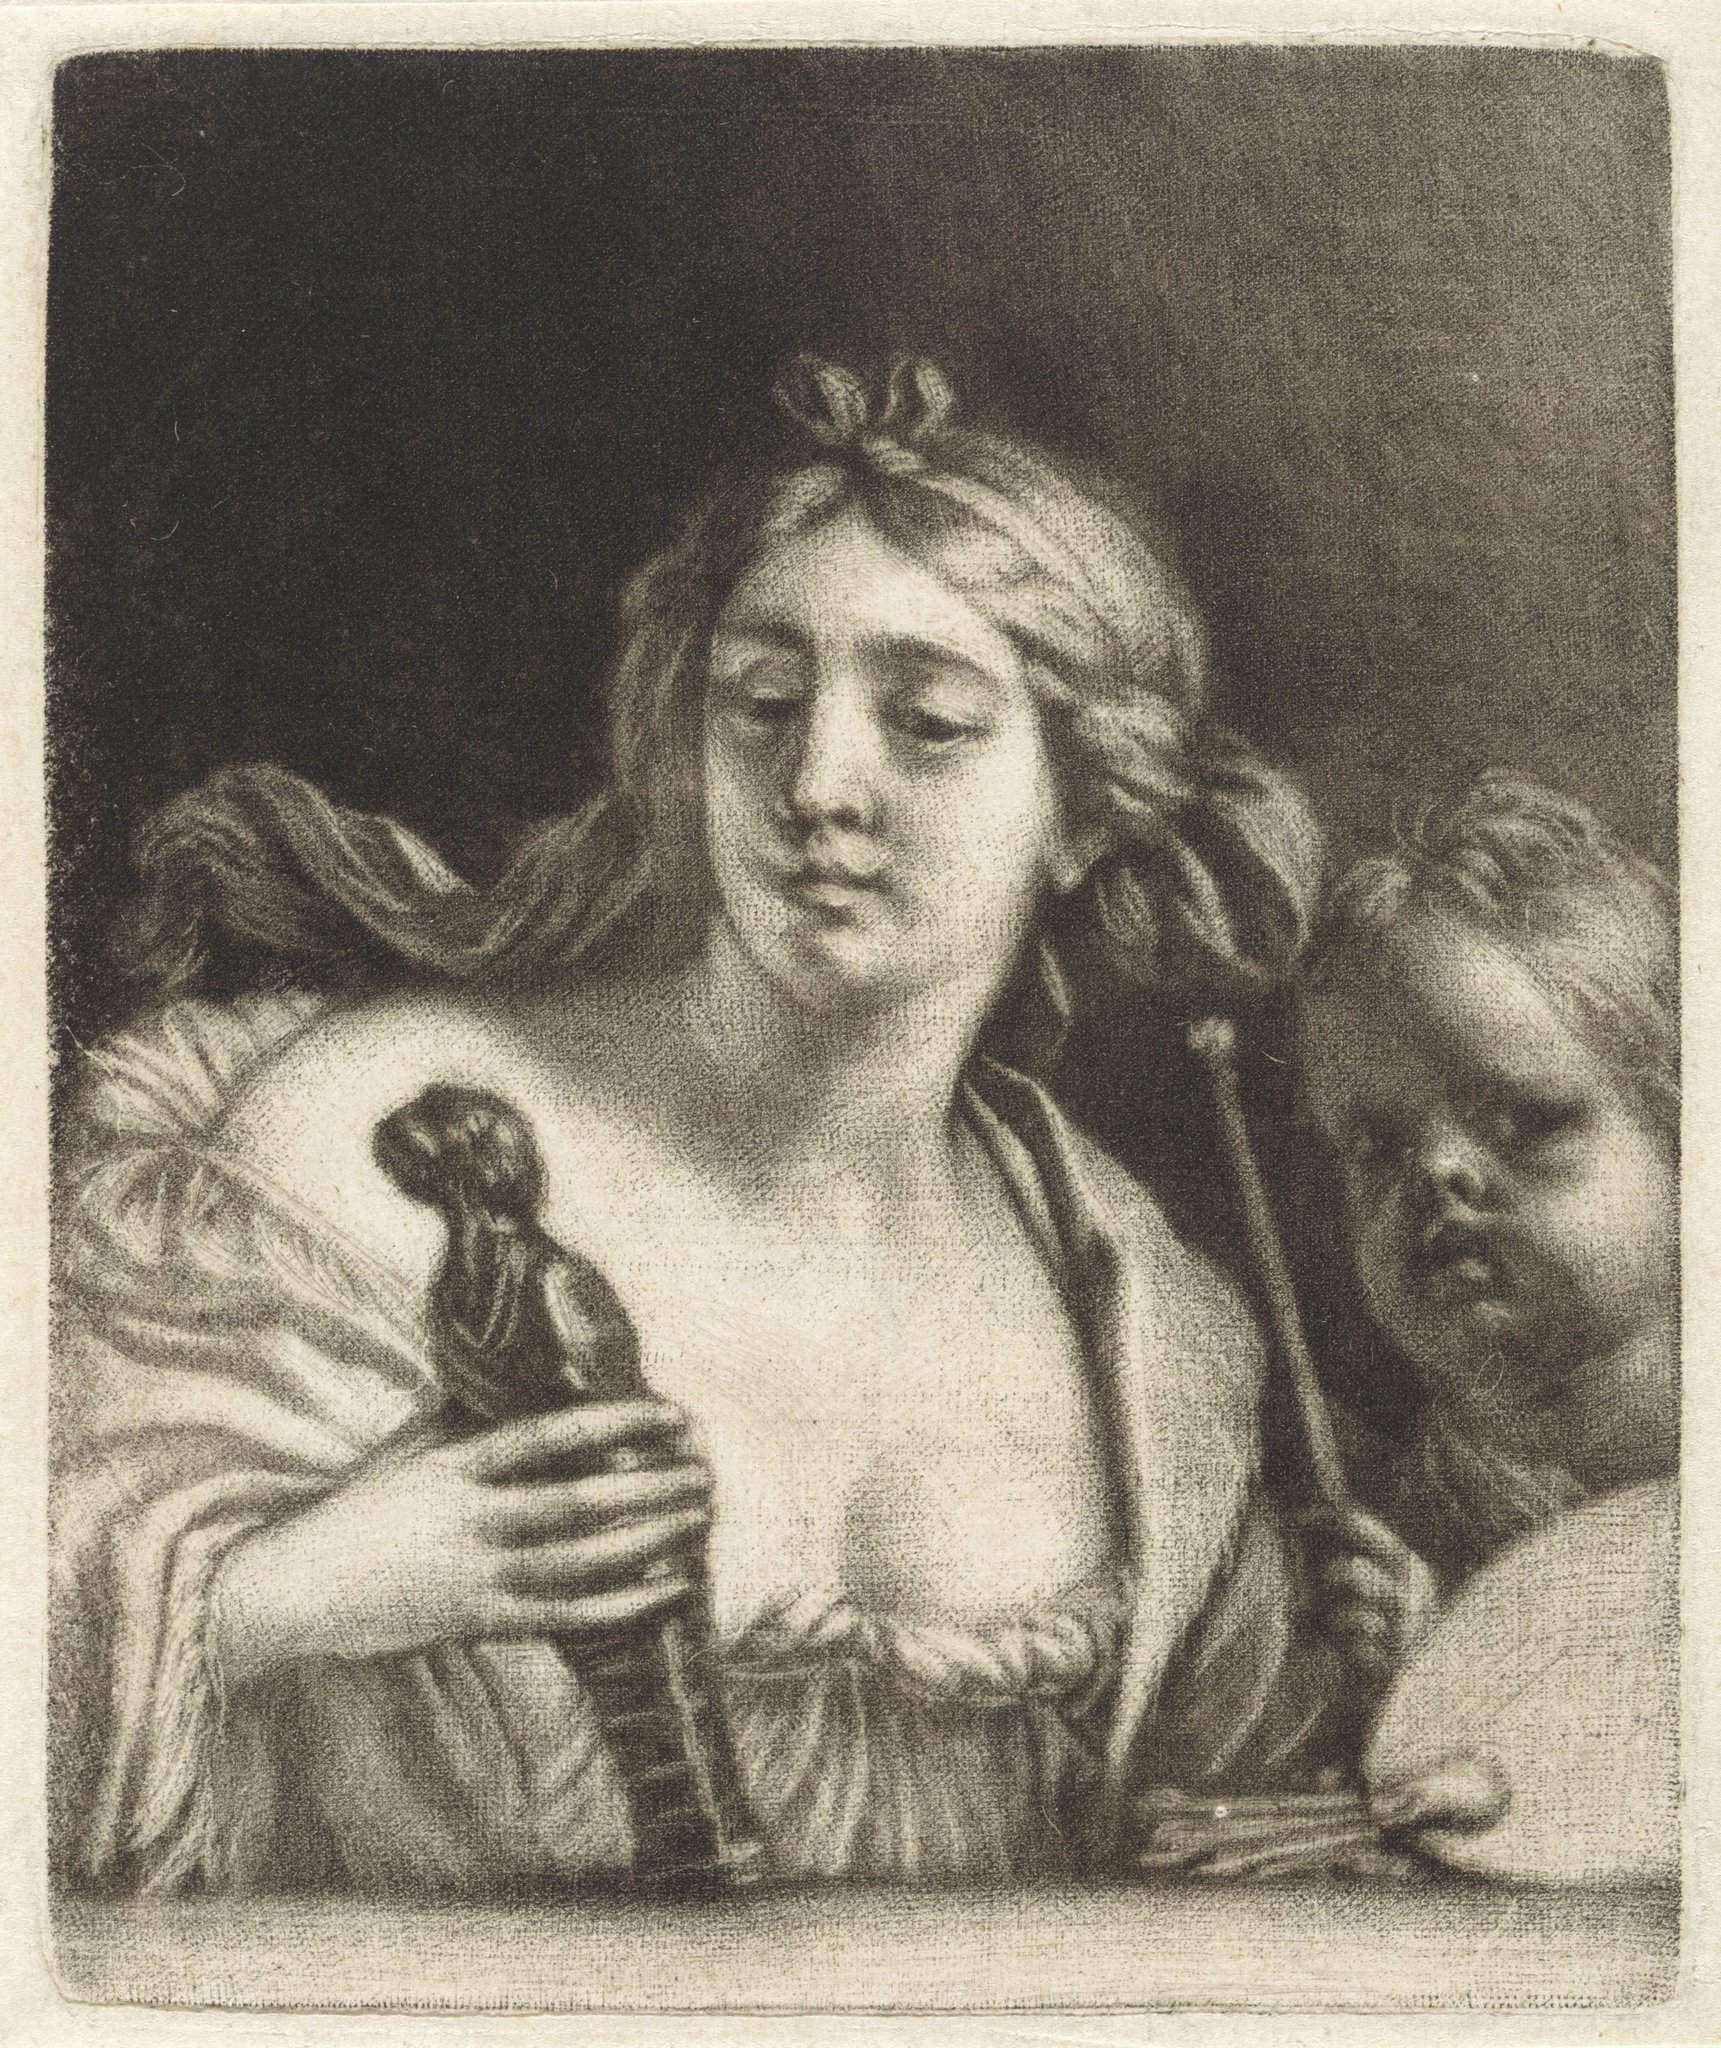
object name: print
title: Allegorie op de Schilderkunst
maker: gerard de lairesse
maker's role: draughtsman, painter, print maker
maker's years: 1641-1711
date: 1670-1680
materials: paper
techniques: mezzotint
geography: amsterdam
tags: 'pictura', symbolic representations, allegories and emblems ~ painting; 'pittura' (ripa), palette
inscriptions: collector's mark: Lugt 240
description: Een vrouw en een kind met een beeldje en een schilderspalet.